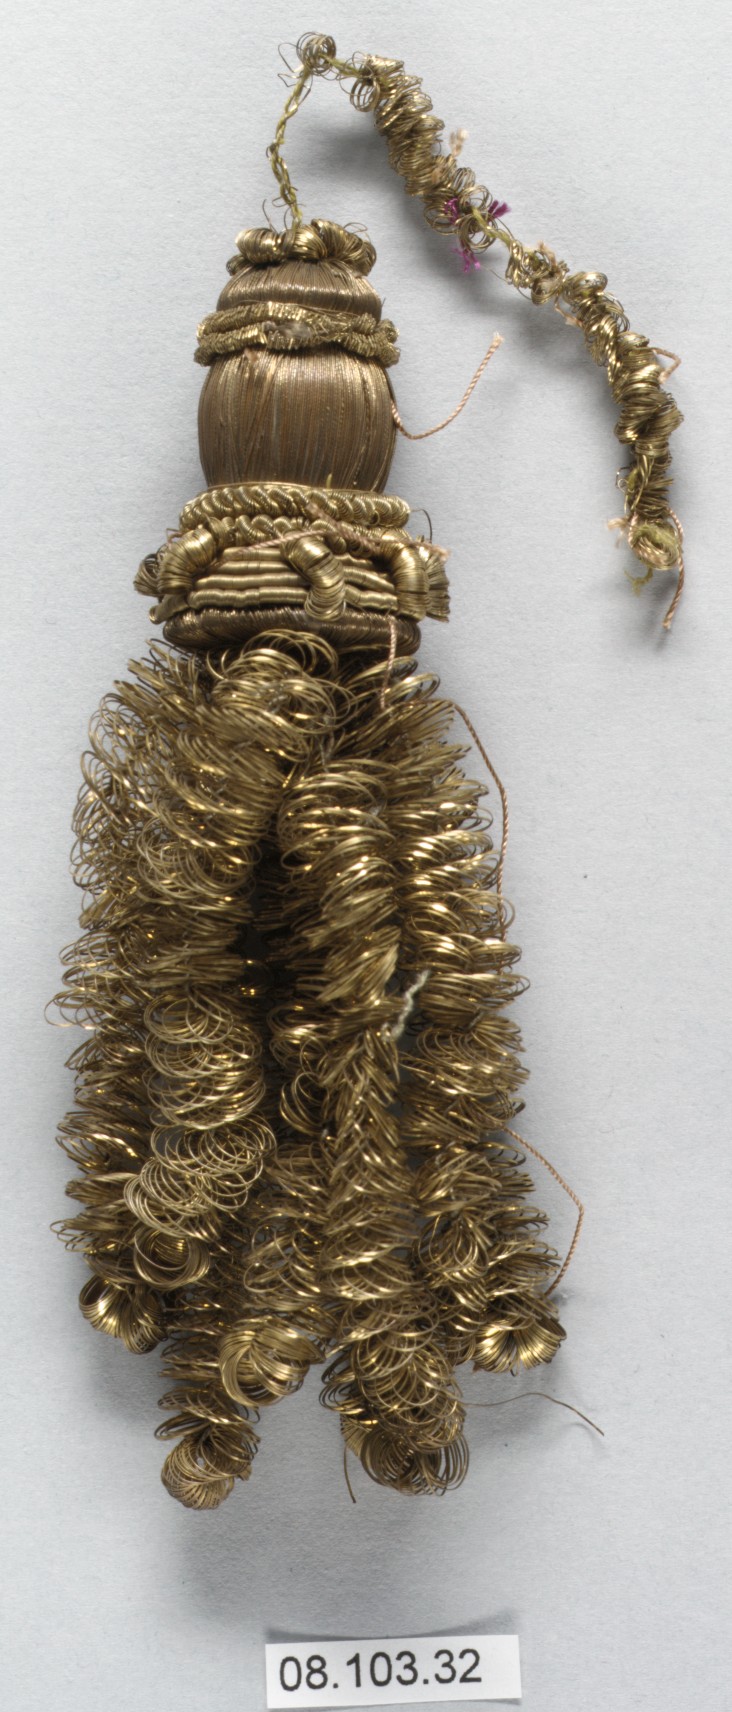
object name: tassel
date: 1801-1833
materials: metal thread